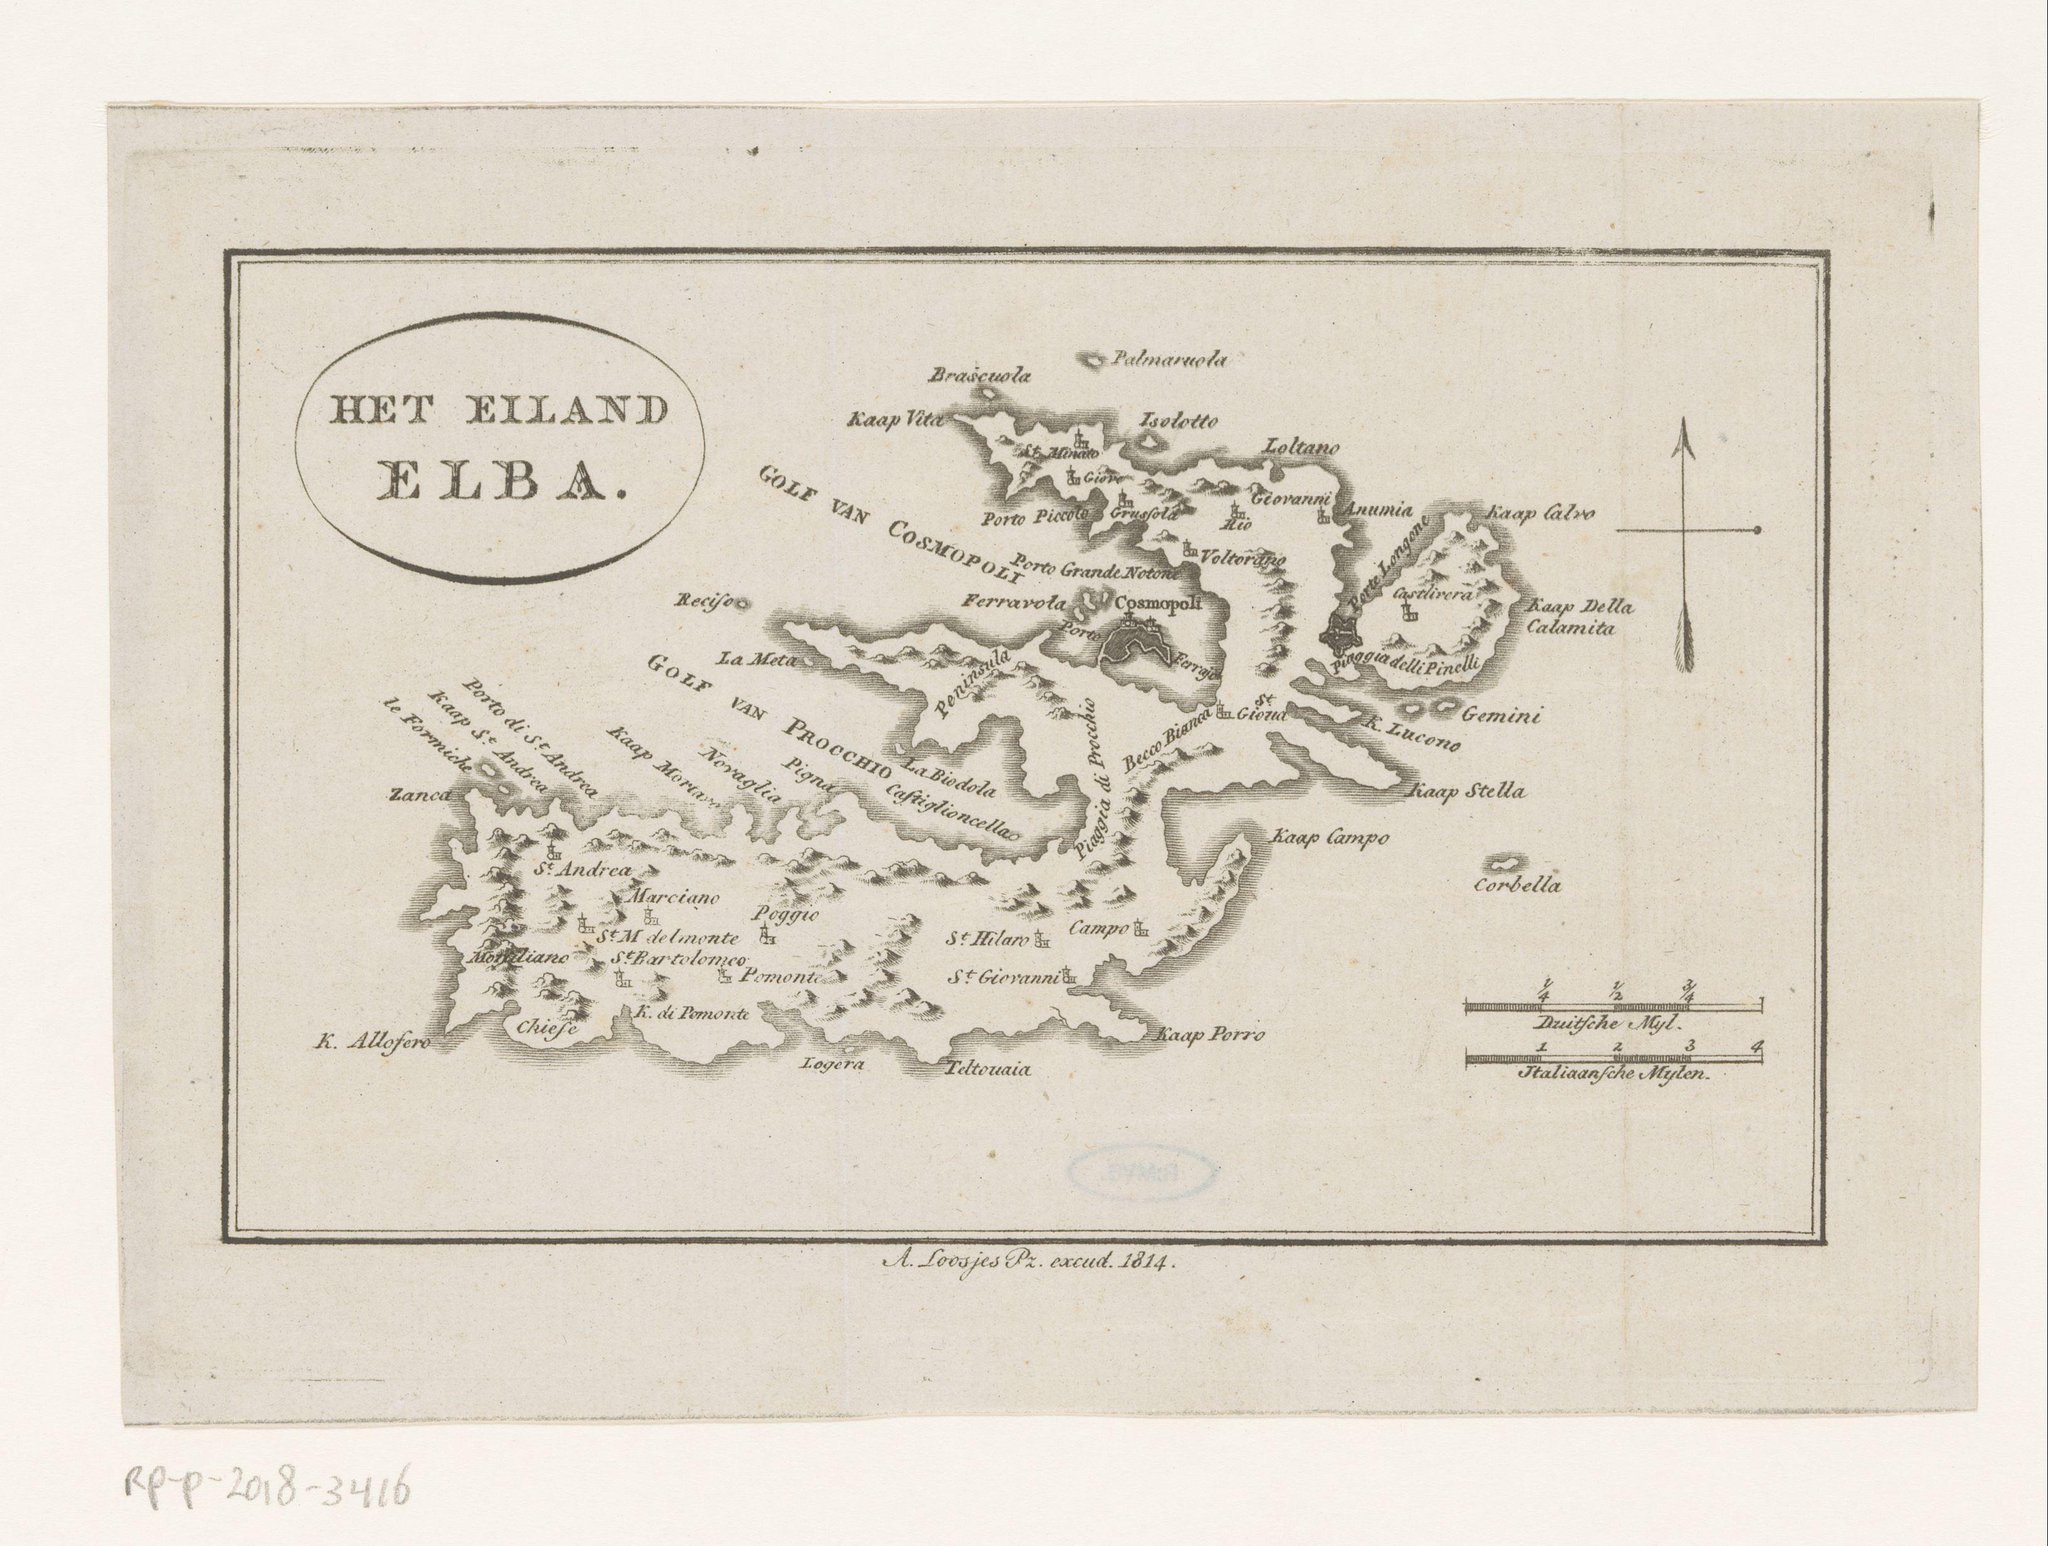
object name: print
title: Kaart van het eiland Elba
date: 1814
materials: paper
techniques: etching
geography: amsterdam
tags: island, maps, atlases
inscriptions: collector's mark: Lugt 2228